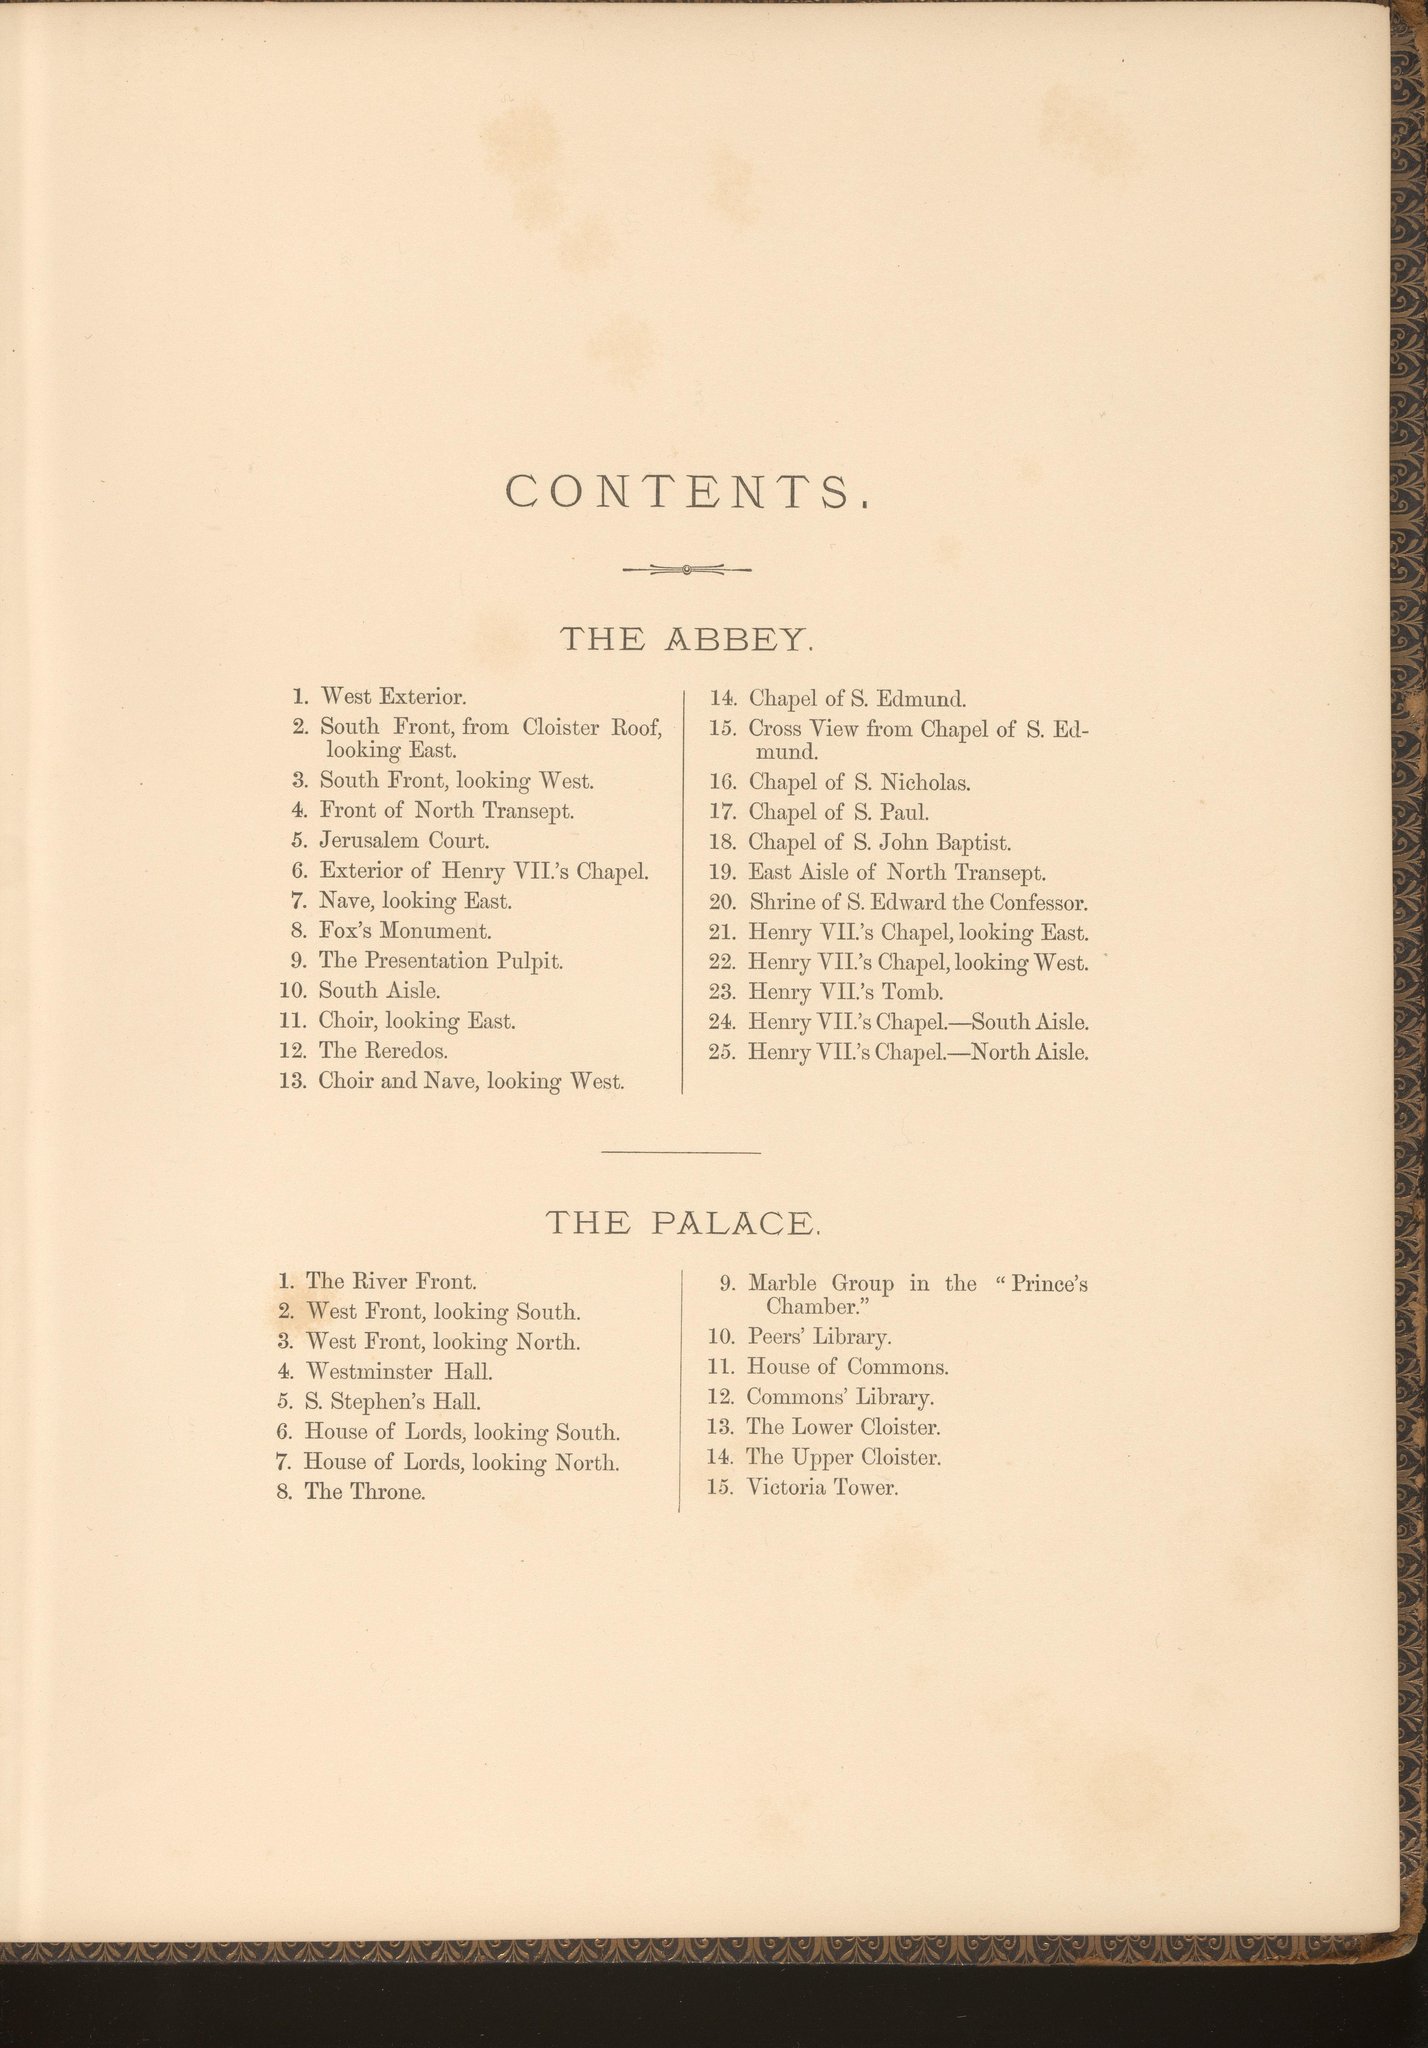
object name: page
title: Westminster Abbey, gezien vanaf het dak van het klooster kijkend naar het oosten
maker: john harrington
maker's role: fotograaf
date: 1864-1869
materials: photographic support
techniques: albumen print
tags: abbey, monastery, convent ~ roman catholic church, church (exterior), westminster abbey